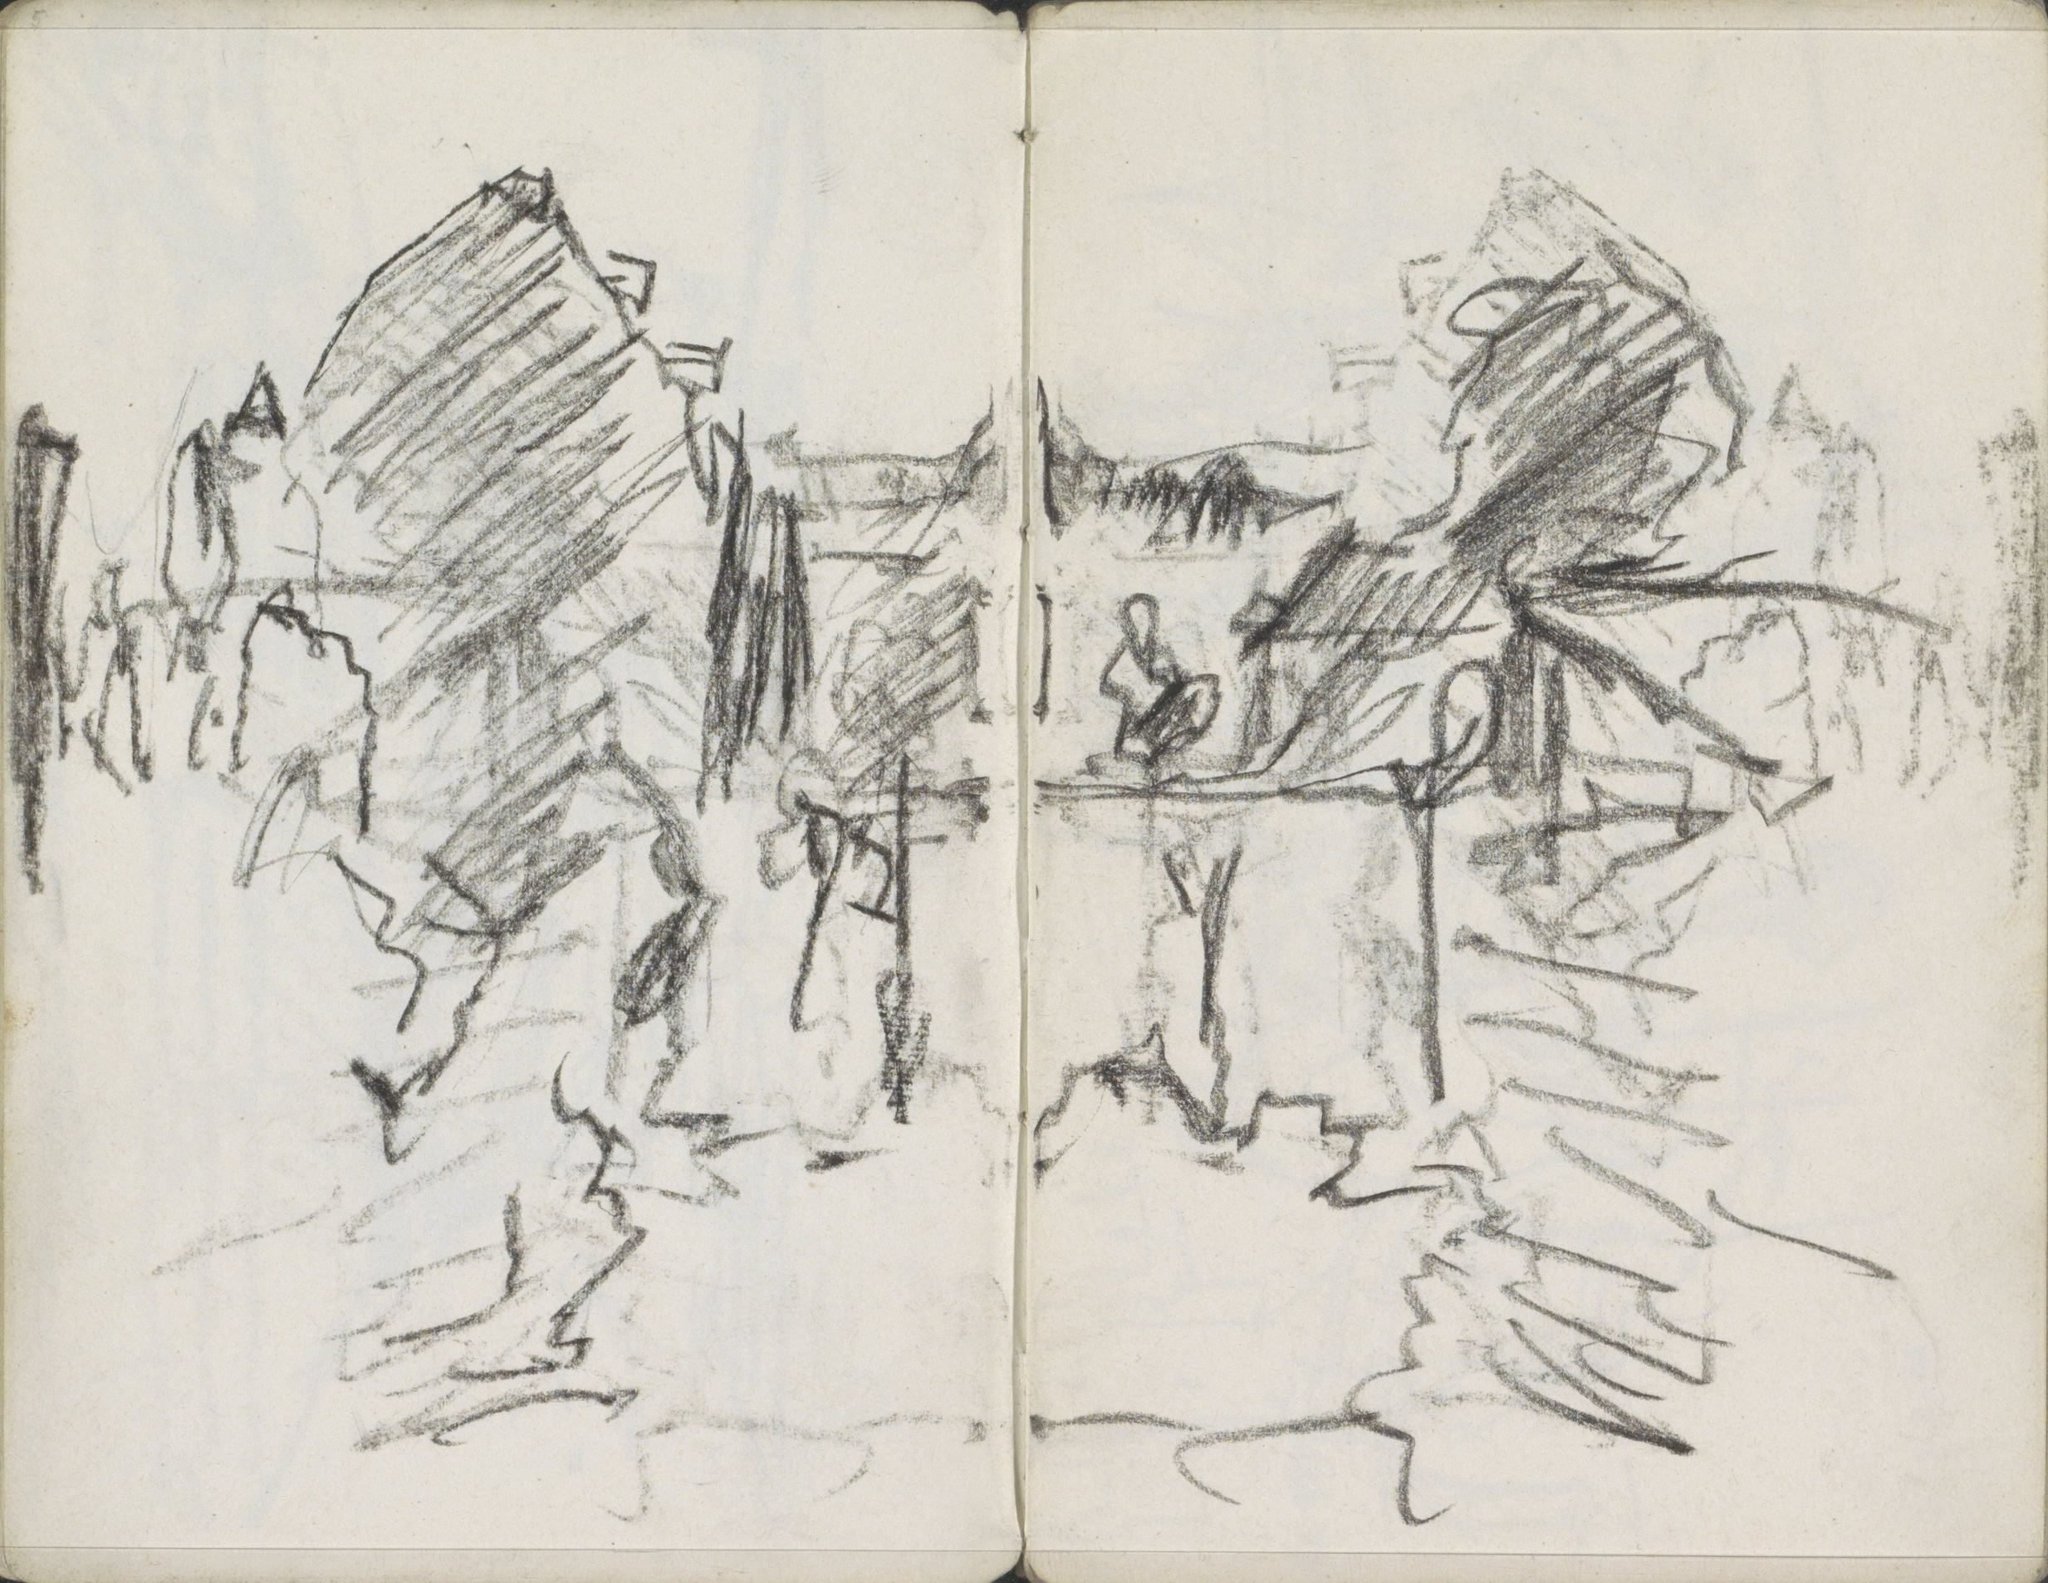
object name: sketchbook leaf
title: Gezicht in Amsterdam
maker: george hendrik breitner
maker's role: draughtsman, painter, print maker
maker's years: 1857-1923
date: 1917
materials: chalk, paper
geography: amsterdam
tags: city-view, and landscape with man-made constructions, civic architecture; edifices; dwellings, amsterdam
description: Pagina 5 en pagina 6 uit een schetsboek met 44 bladen.